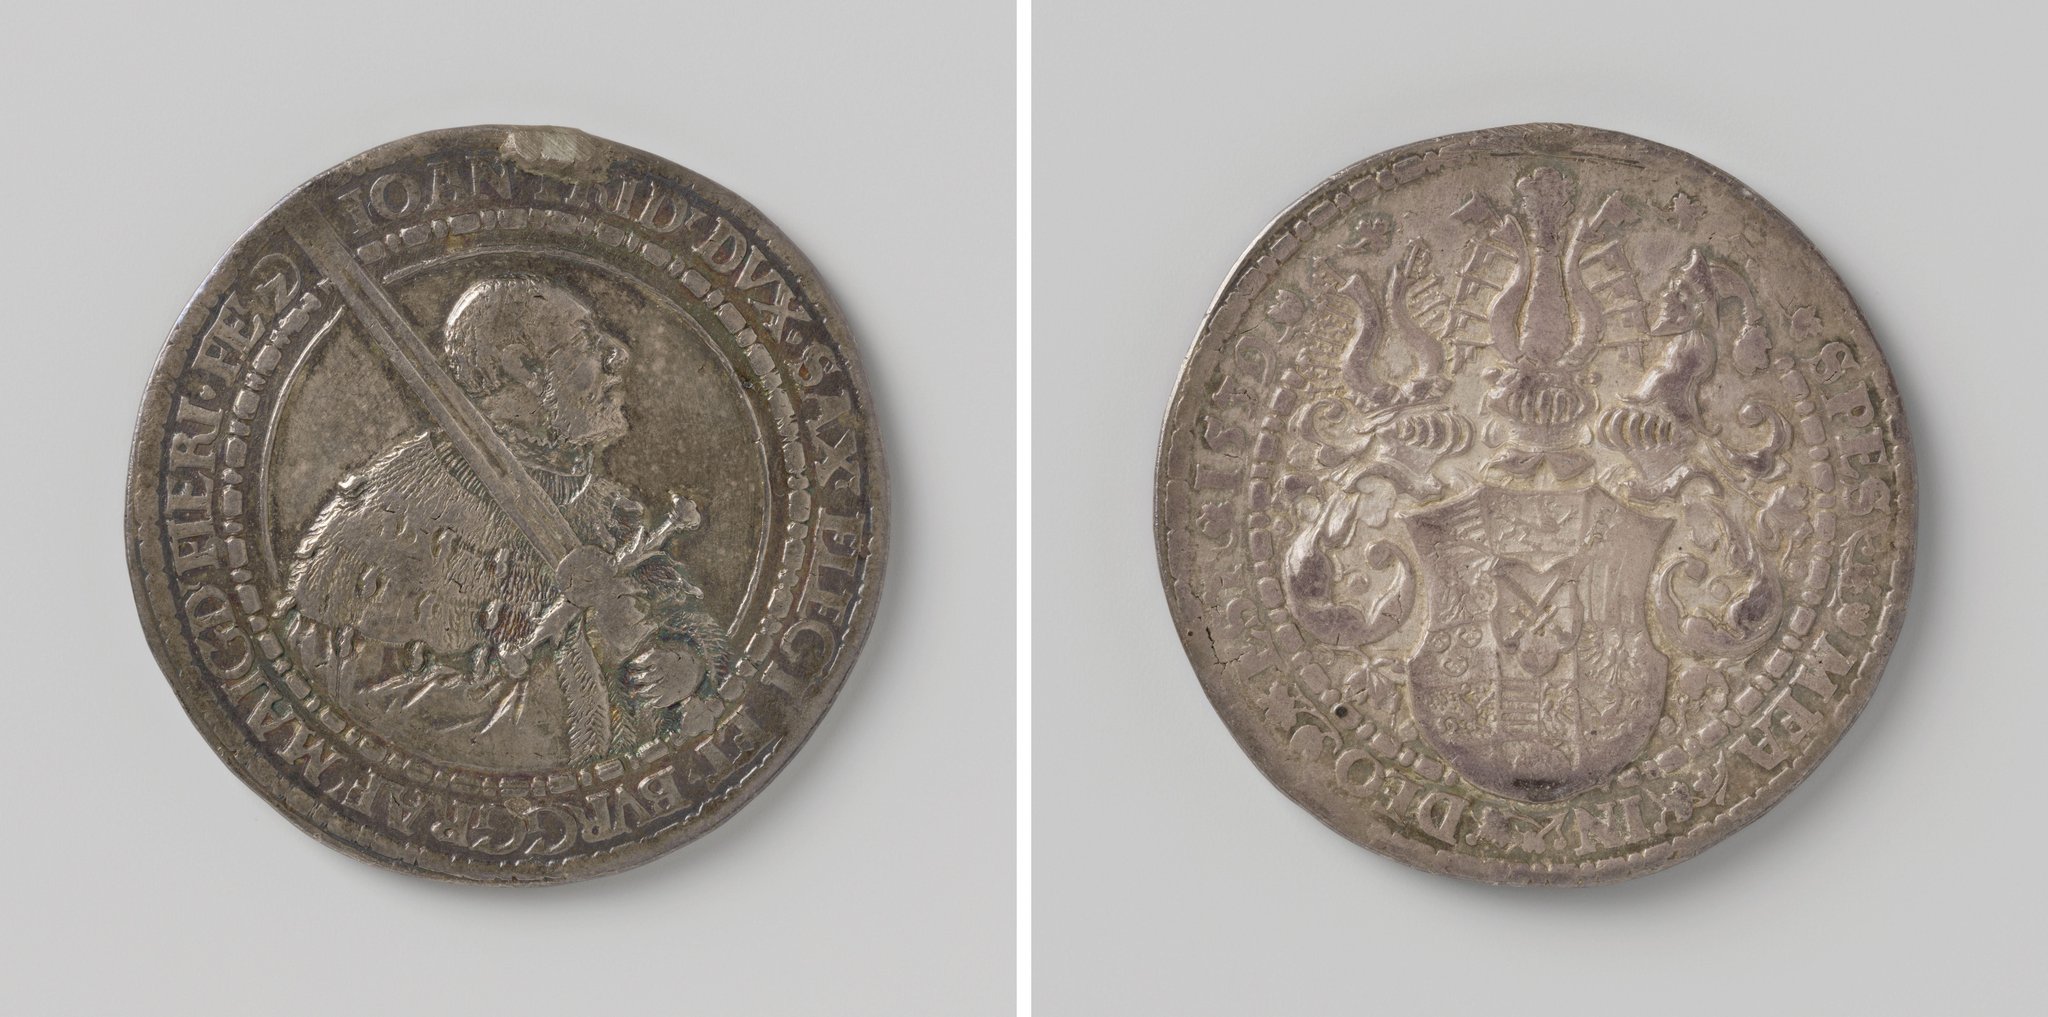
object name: history medal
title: Johan Frederik de Grootmoedige, keurvorst van Saksen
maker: Anonymous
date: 1539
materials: silver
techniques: striking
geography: germany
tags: weimar, keurvorst, johan frederik i (keurvorst van saksen)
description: Zilveren penning. Voorzijde: borststuk man met zwaard over schouders binnen omschrift. Keerzijde: wapenschild gekroond met saksische helmen binnen omschrift